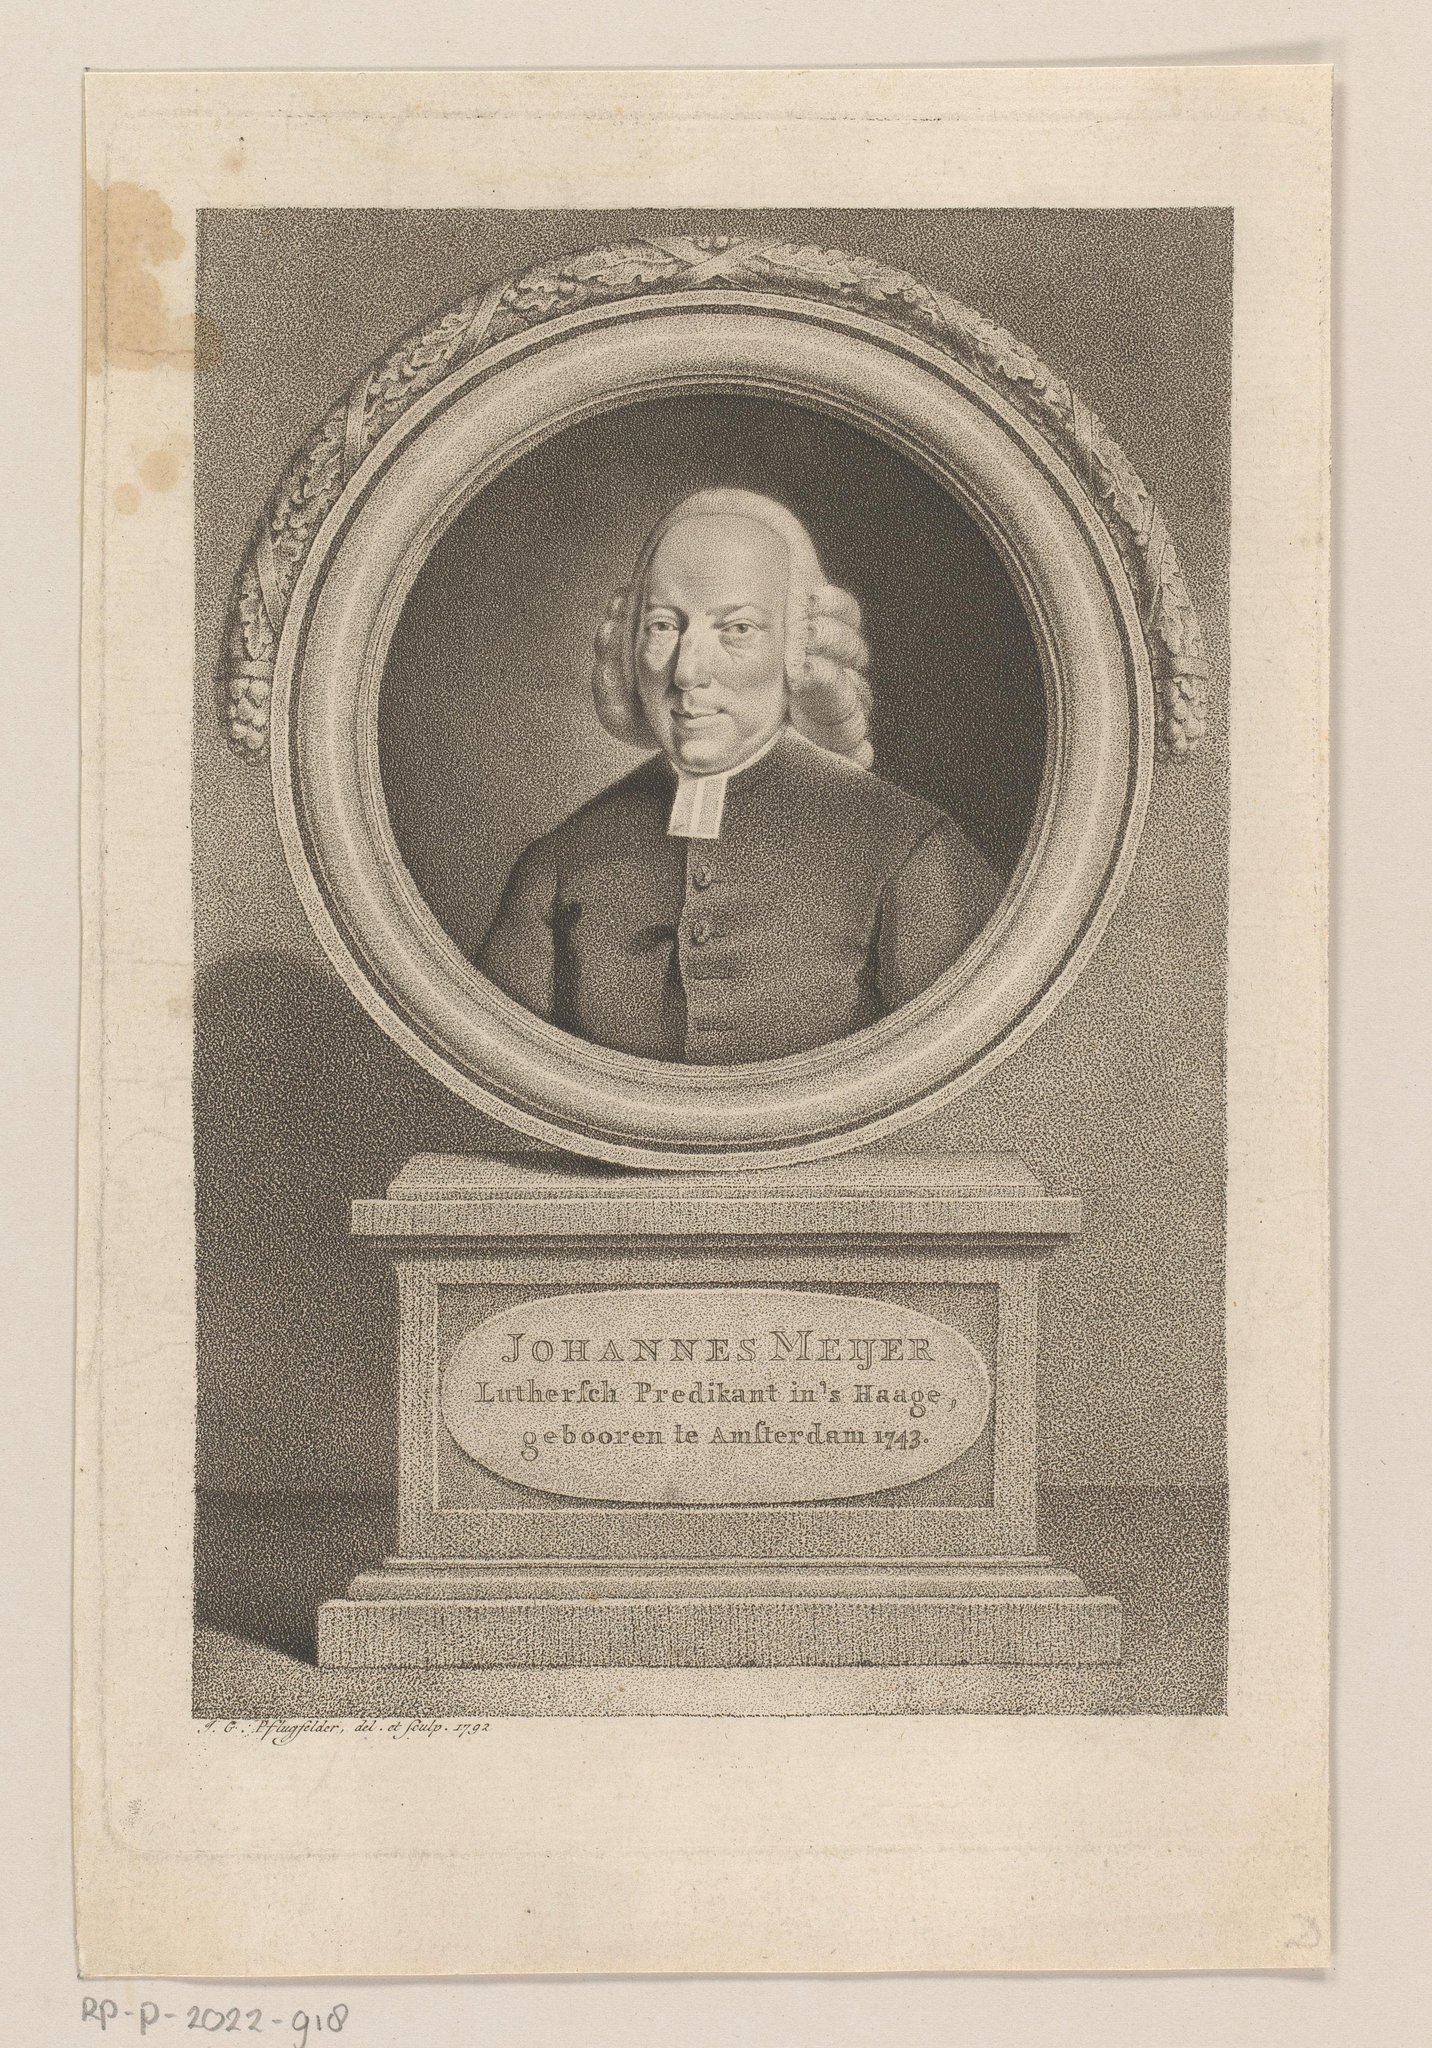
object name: print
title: Portret van Johannes Meijer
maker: johann gottfried pflugfelder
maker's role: print maker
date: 1792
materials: paper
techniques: etching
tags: amsterdam, historical persons, functionaries and dignitaries ~ protestant churches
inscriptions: collector's mark: Lugt 2228